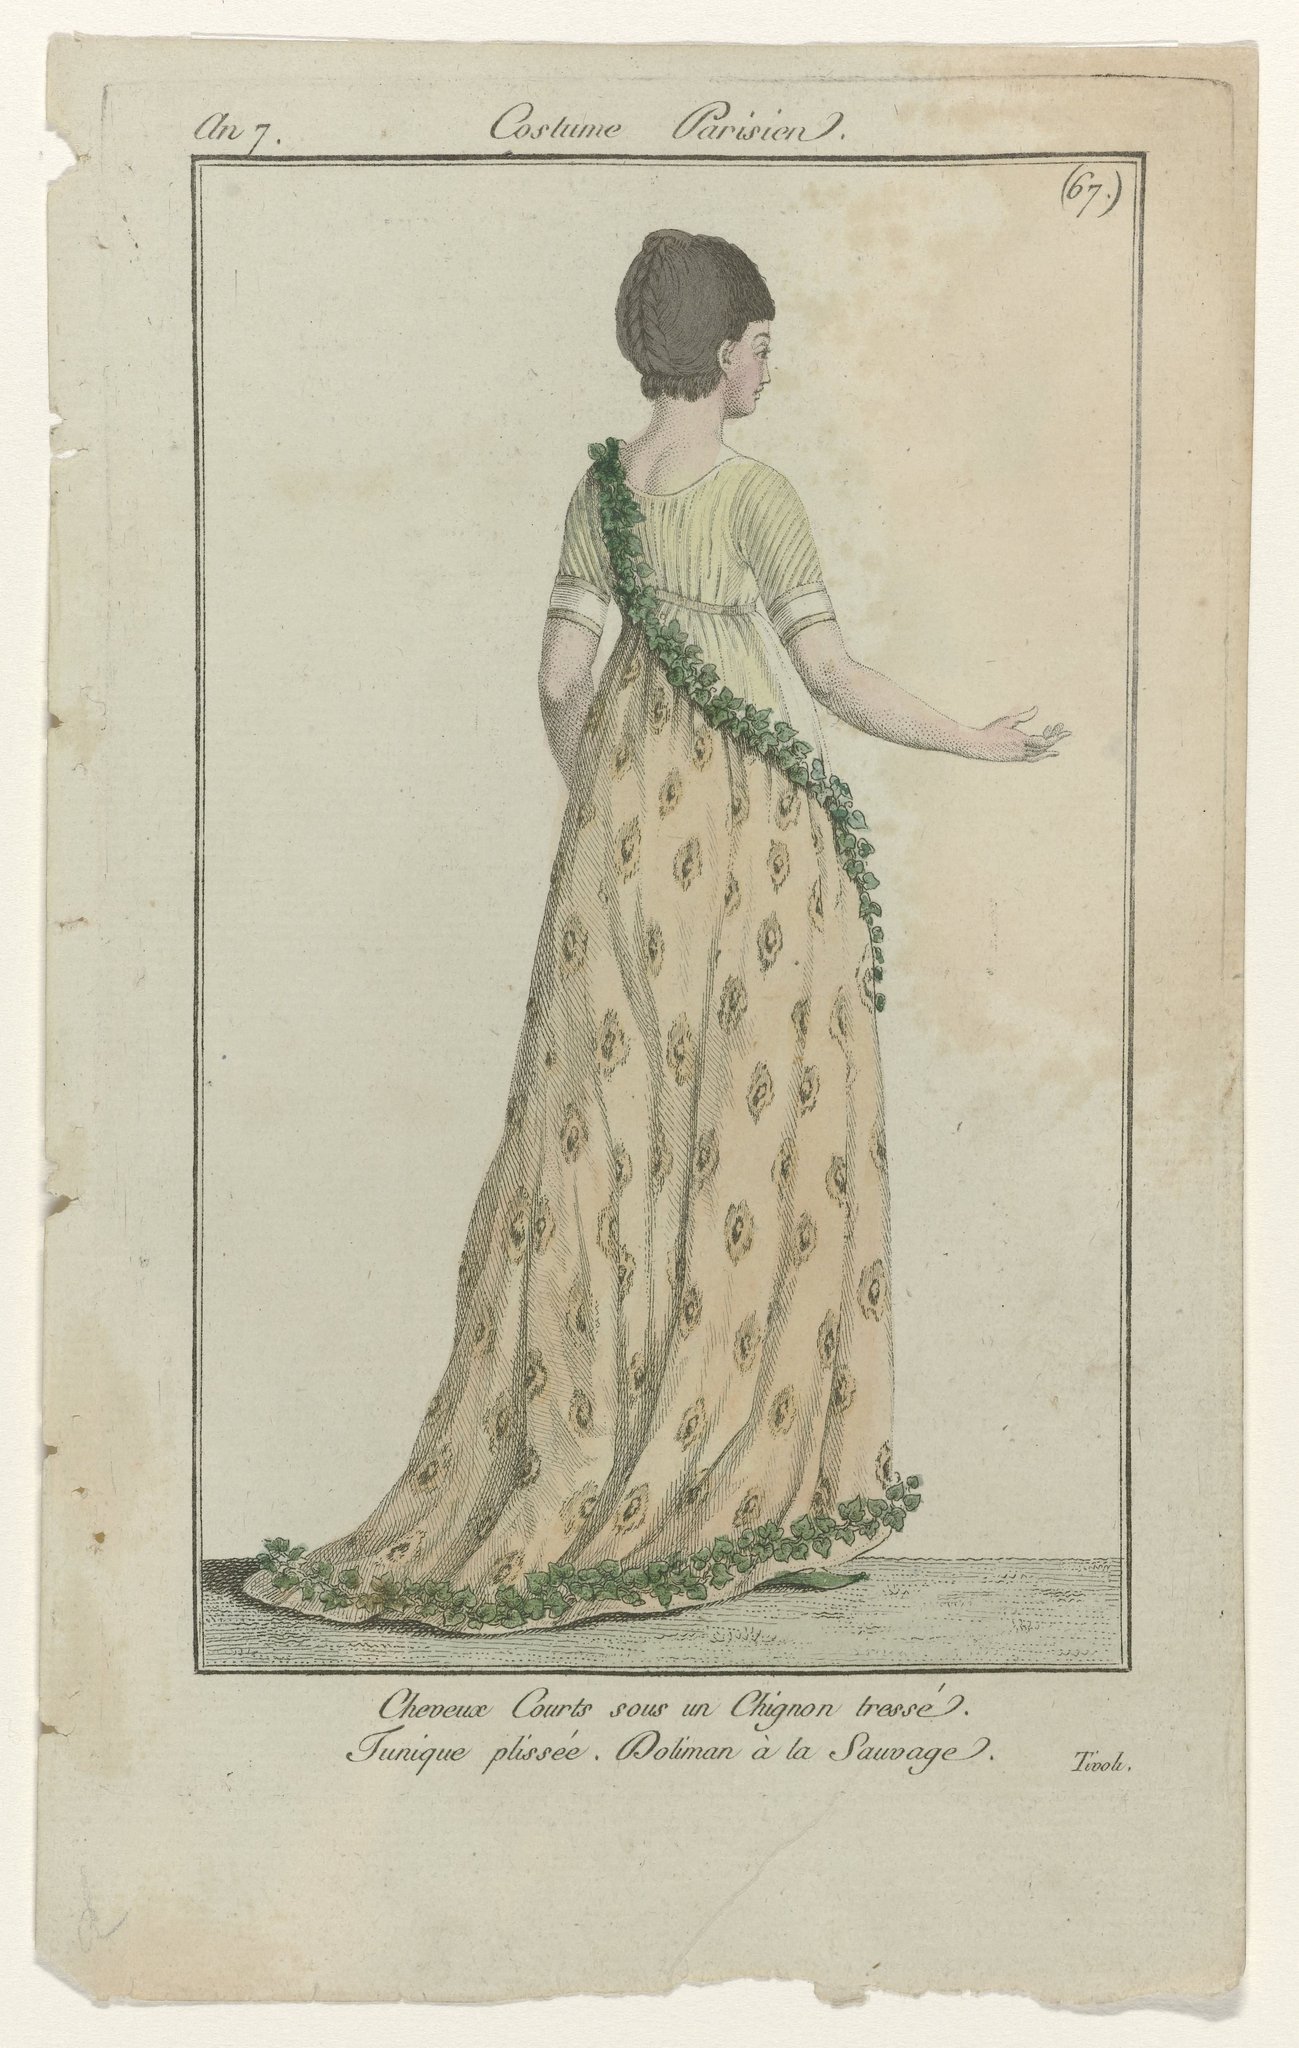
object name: fashion print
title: Journal des Dames et des Modes, Costume Parisien, 11 octobre 1798, An 7 (67) : Cheveux Courts (...)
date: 1798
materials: paper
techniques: engraving, hand coloring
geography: paris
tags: dress, gown (tunic) (+ women's clothes), styles of hairdress - aa - ~ women, fashion plates, shoes, sandals (+ women's clothes), dress, gown (+ women's clothes)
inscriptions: caption: ‘Cheveux Courts sous un Chignon tressé. Tunique plissée. Doliman à la Sauvage. / Tivoli.’, title: ‘Costume Parisien.’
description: Kapsel in een gevlochten knot met haarkam. Geplooide tuniek met korte mouwen: 'Doliman à la Sauvage', afgezet met klimop. platte schoen met puntige neus. Volgens het onderschrift is dit kostuum naar het leven getekend in 'Tivoli'. De prent maakt deel uit van het modetijdschrift Journal des Dames et des Modes, uitgegeven door Sellèque, Parijs, 1797-1839.